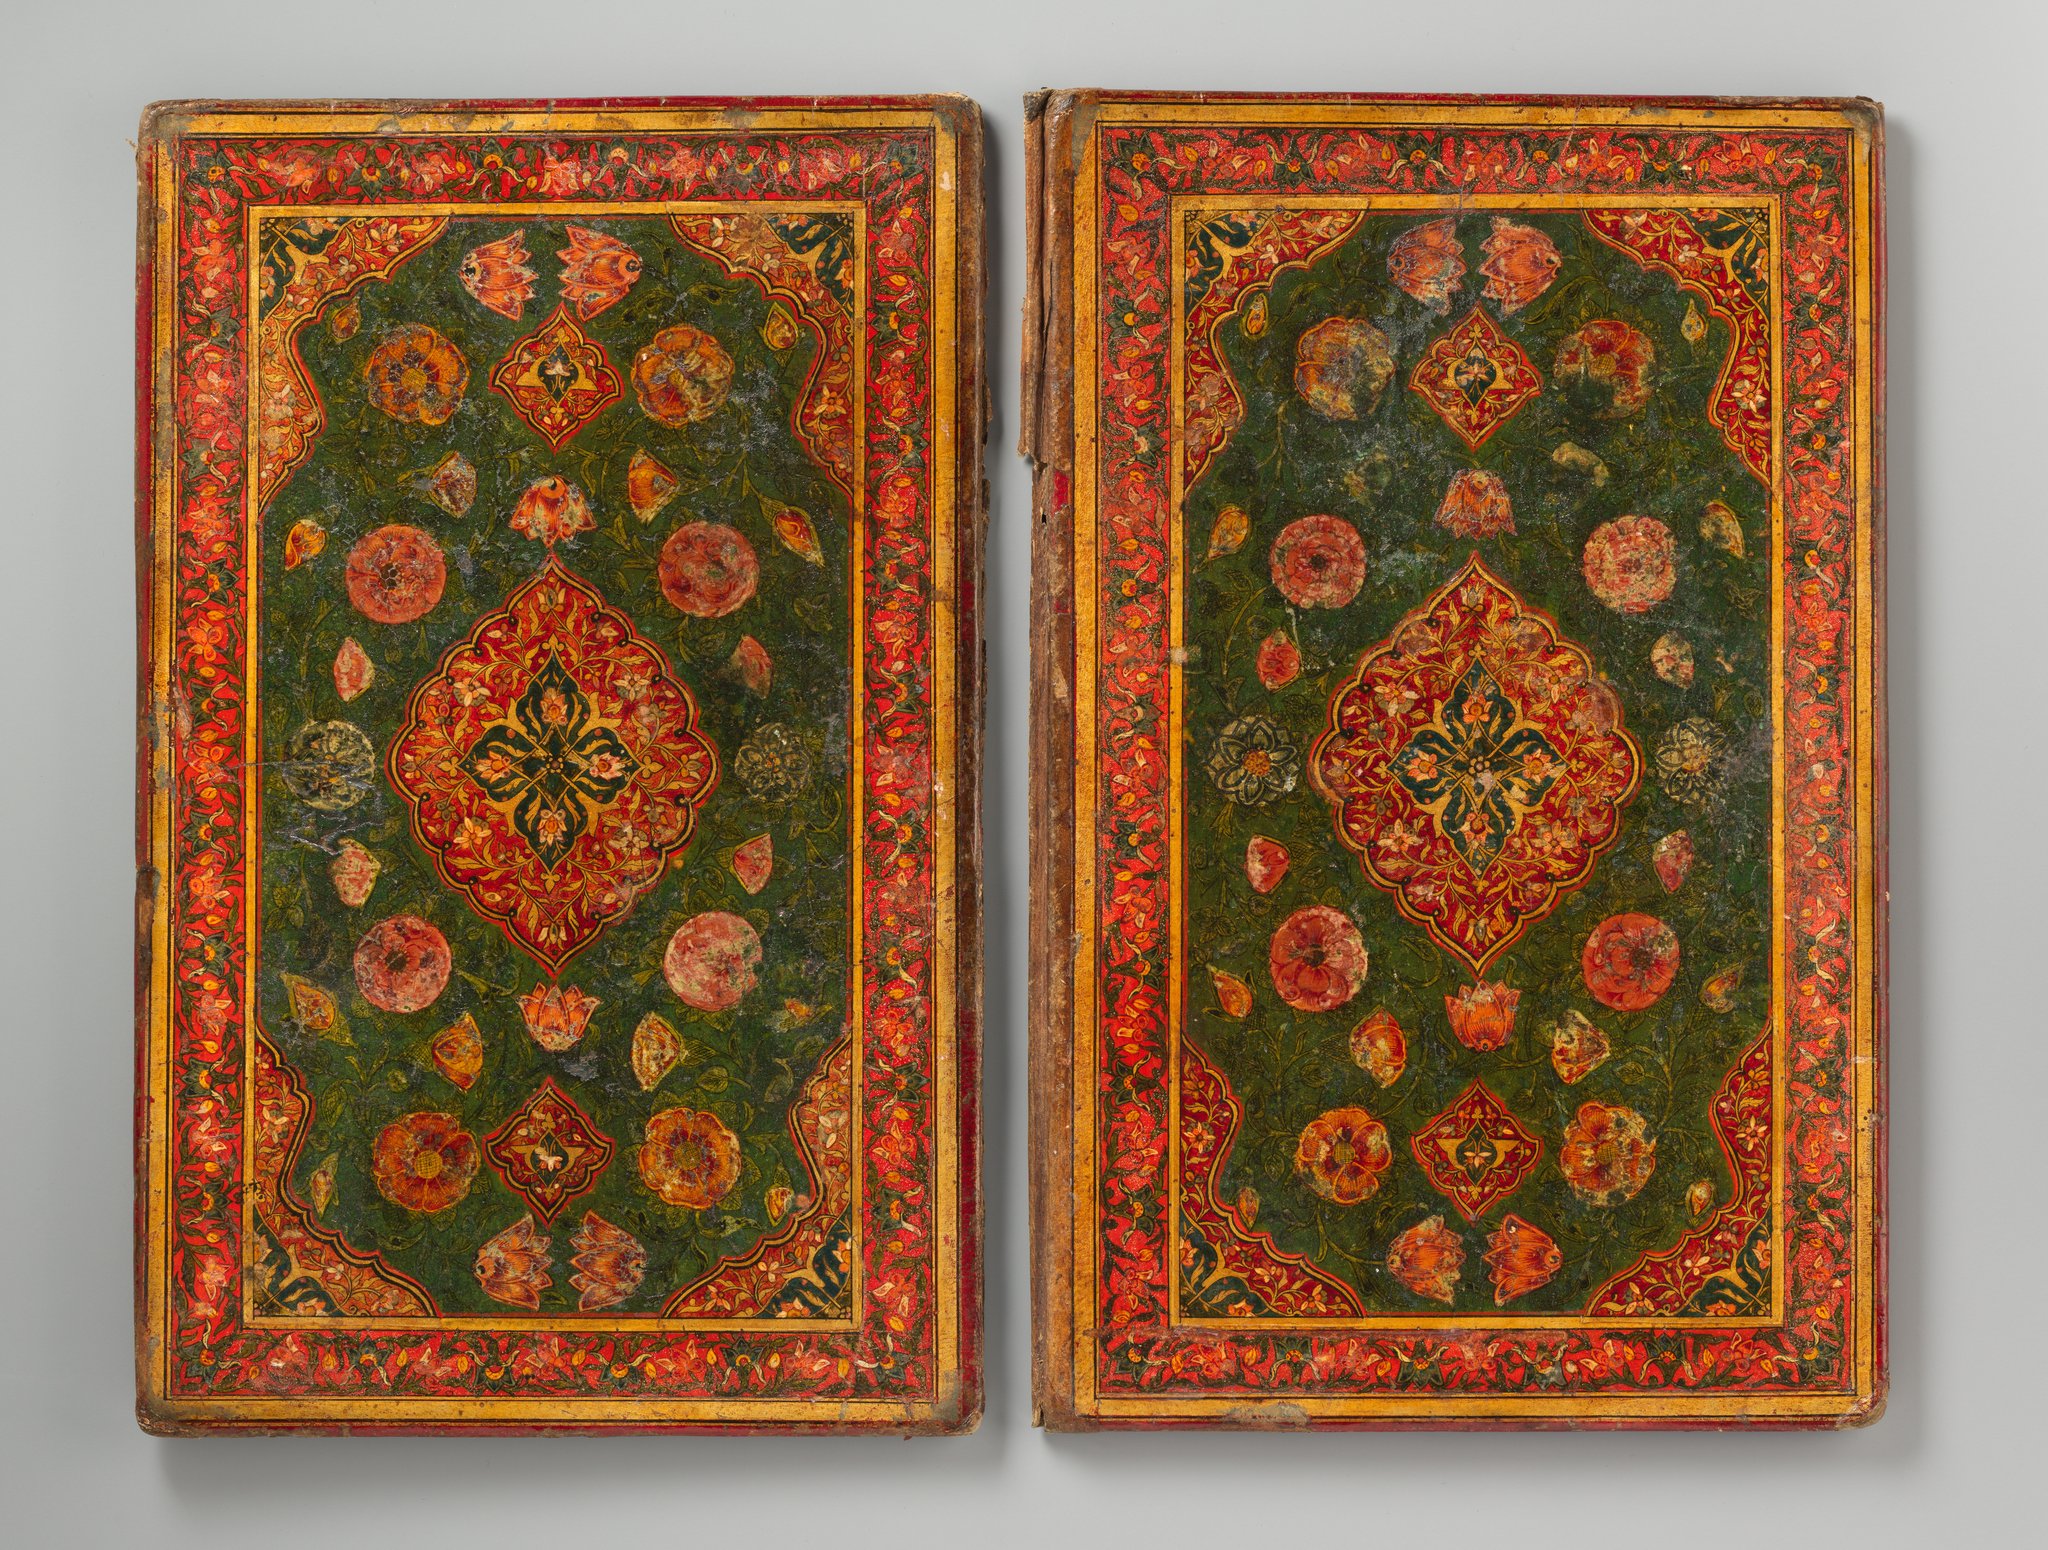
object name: bookbinding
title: Bookbinding (Jild-i kitab)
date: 1701-1900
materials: board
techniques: lacquer, painting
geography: iran